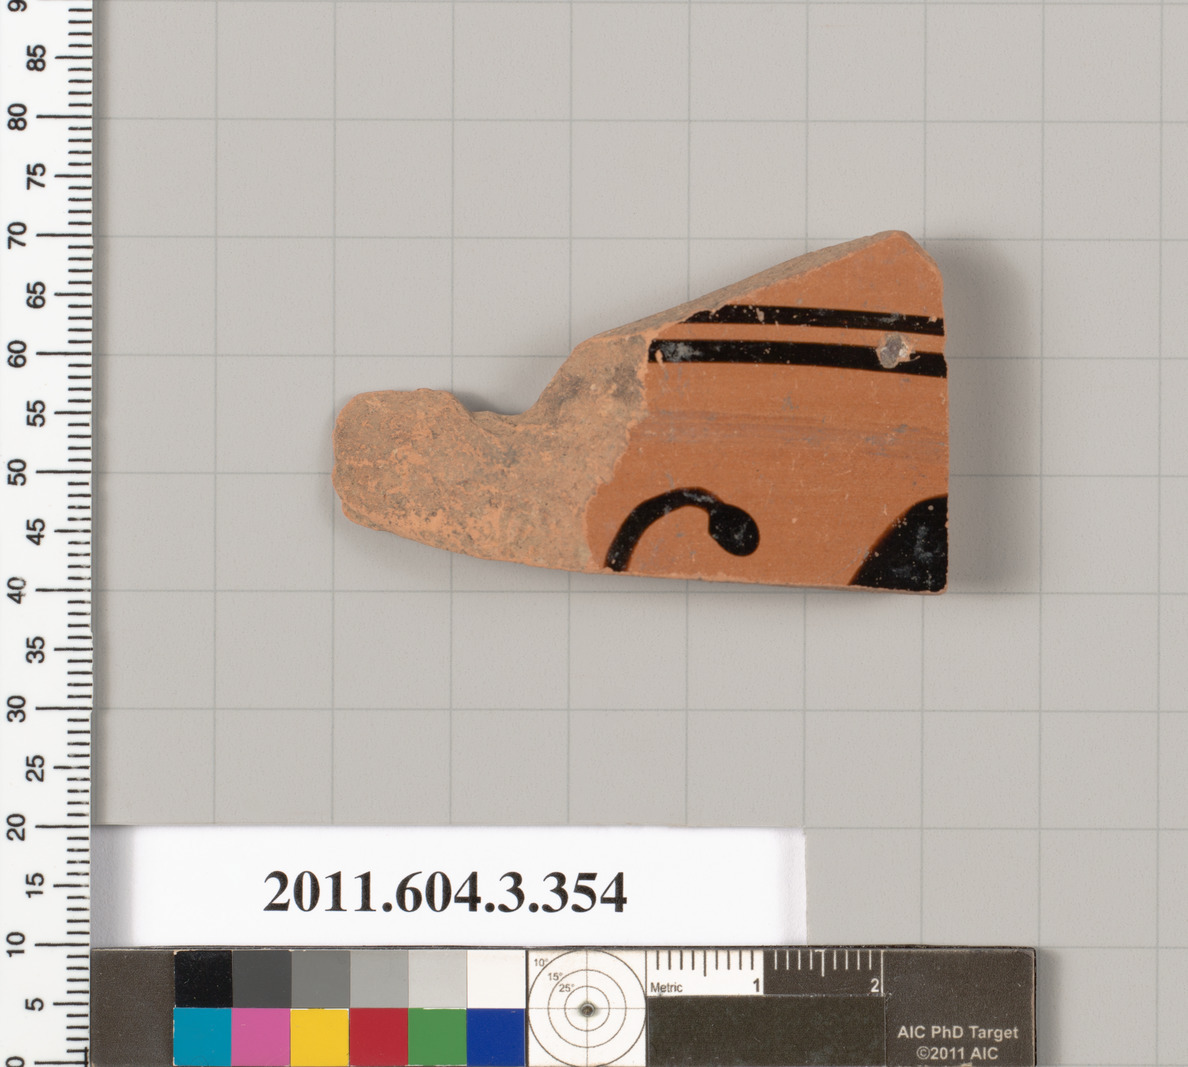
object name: neck amphora fragment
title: Terracotta fragment of a neck-amphora (jar)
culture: greek, attic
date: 550-526 BCE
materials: terracotta